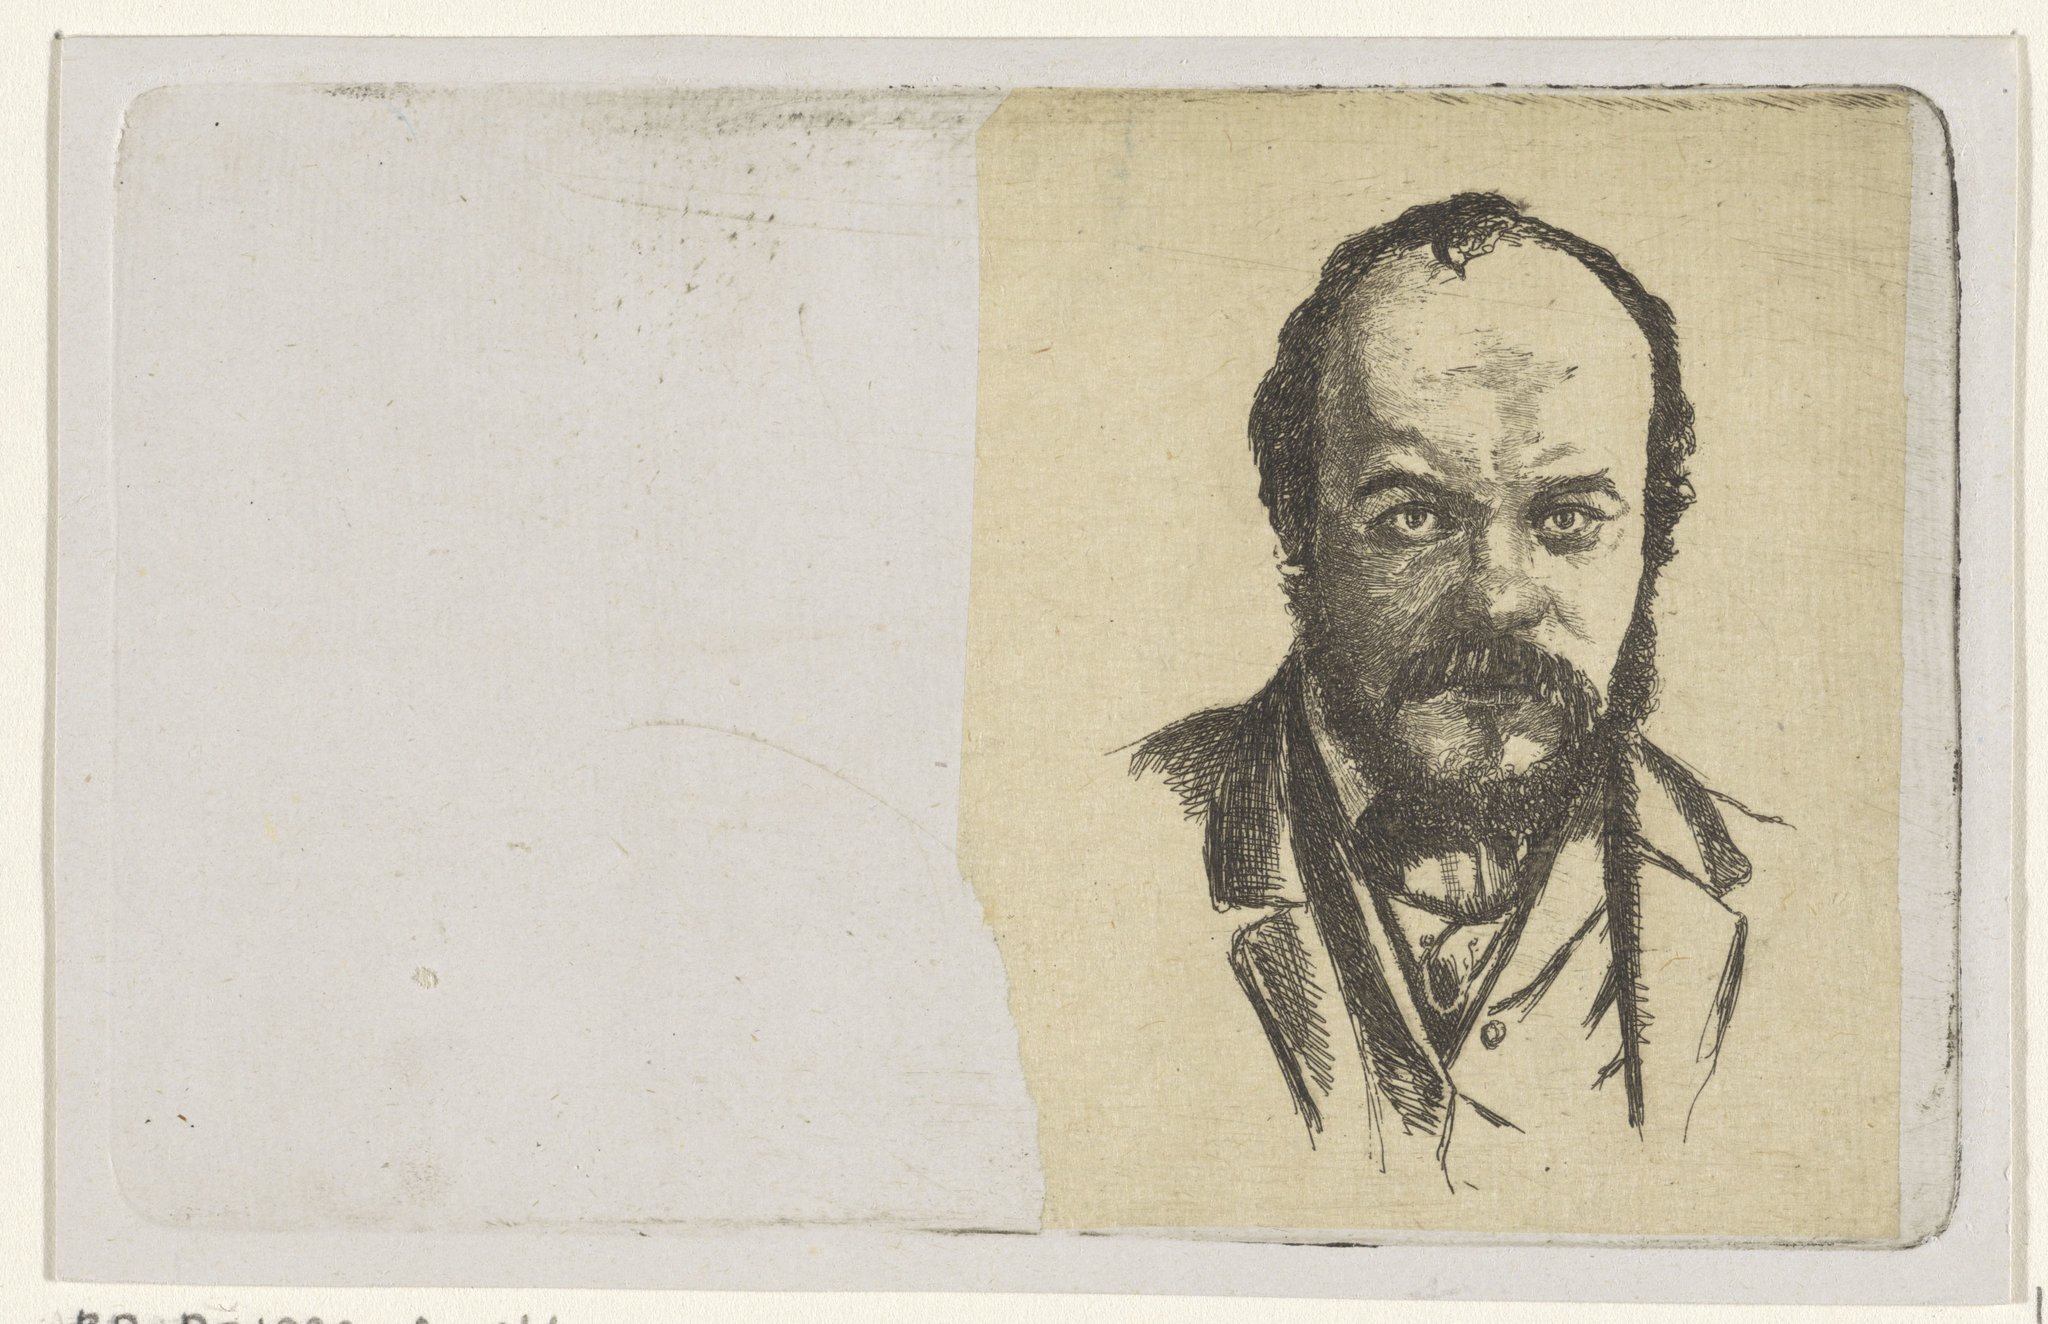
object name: print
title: Portret van Jan Weissenbruch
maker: frederik hendrik weissenbruch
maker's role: draughtsman, print maker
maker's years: 1828-1887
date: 1863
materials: paper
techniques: etching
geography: the hague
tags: the hague, painter, print maker, jan weissenbruch, historical persons, portrait, self-portrait of artist, beard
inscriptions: collector's mark: Lugt 2228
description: Portret van de kunstenaar Jan Weissenbruch, oudere broer en leermeester van de vervaardigend kunstenaar.